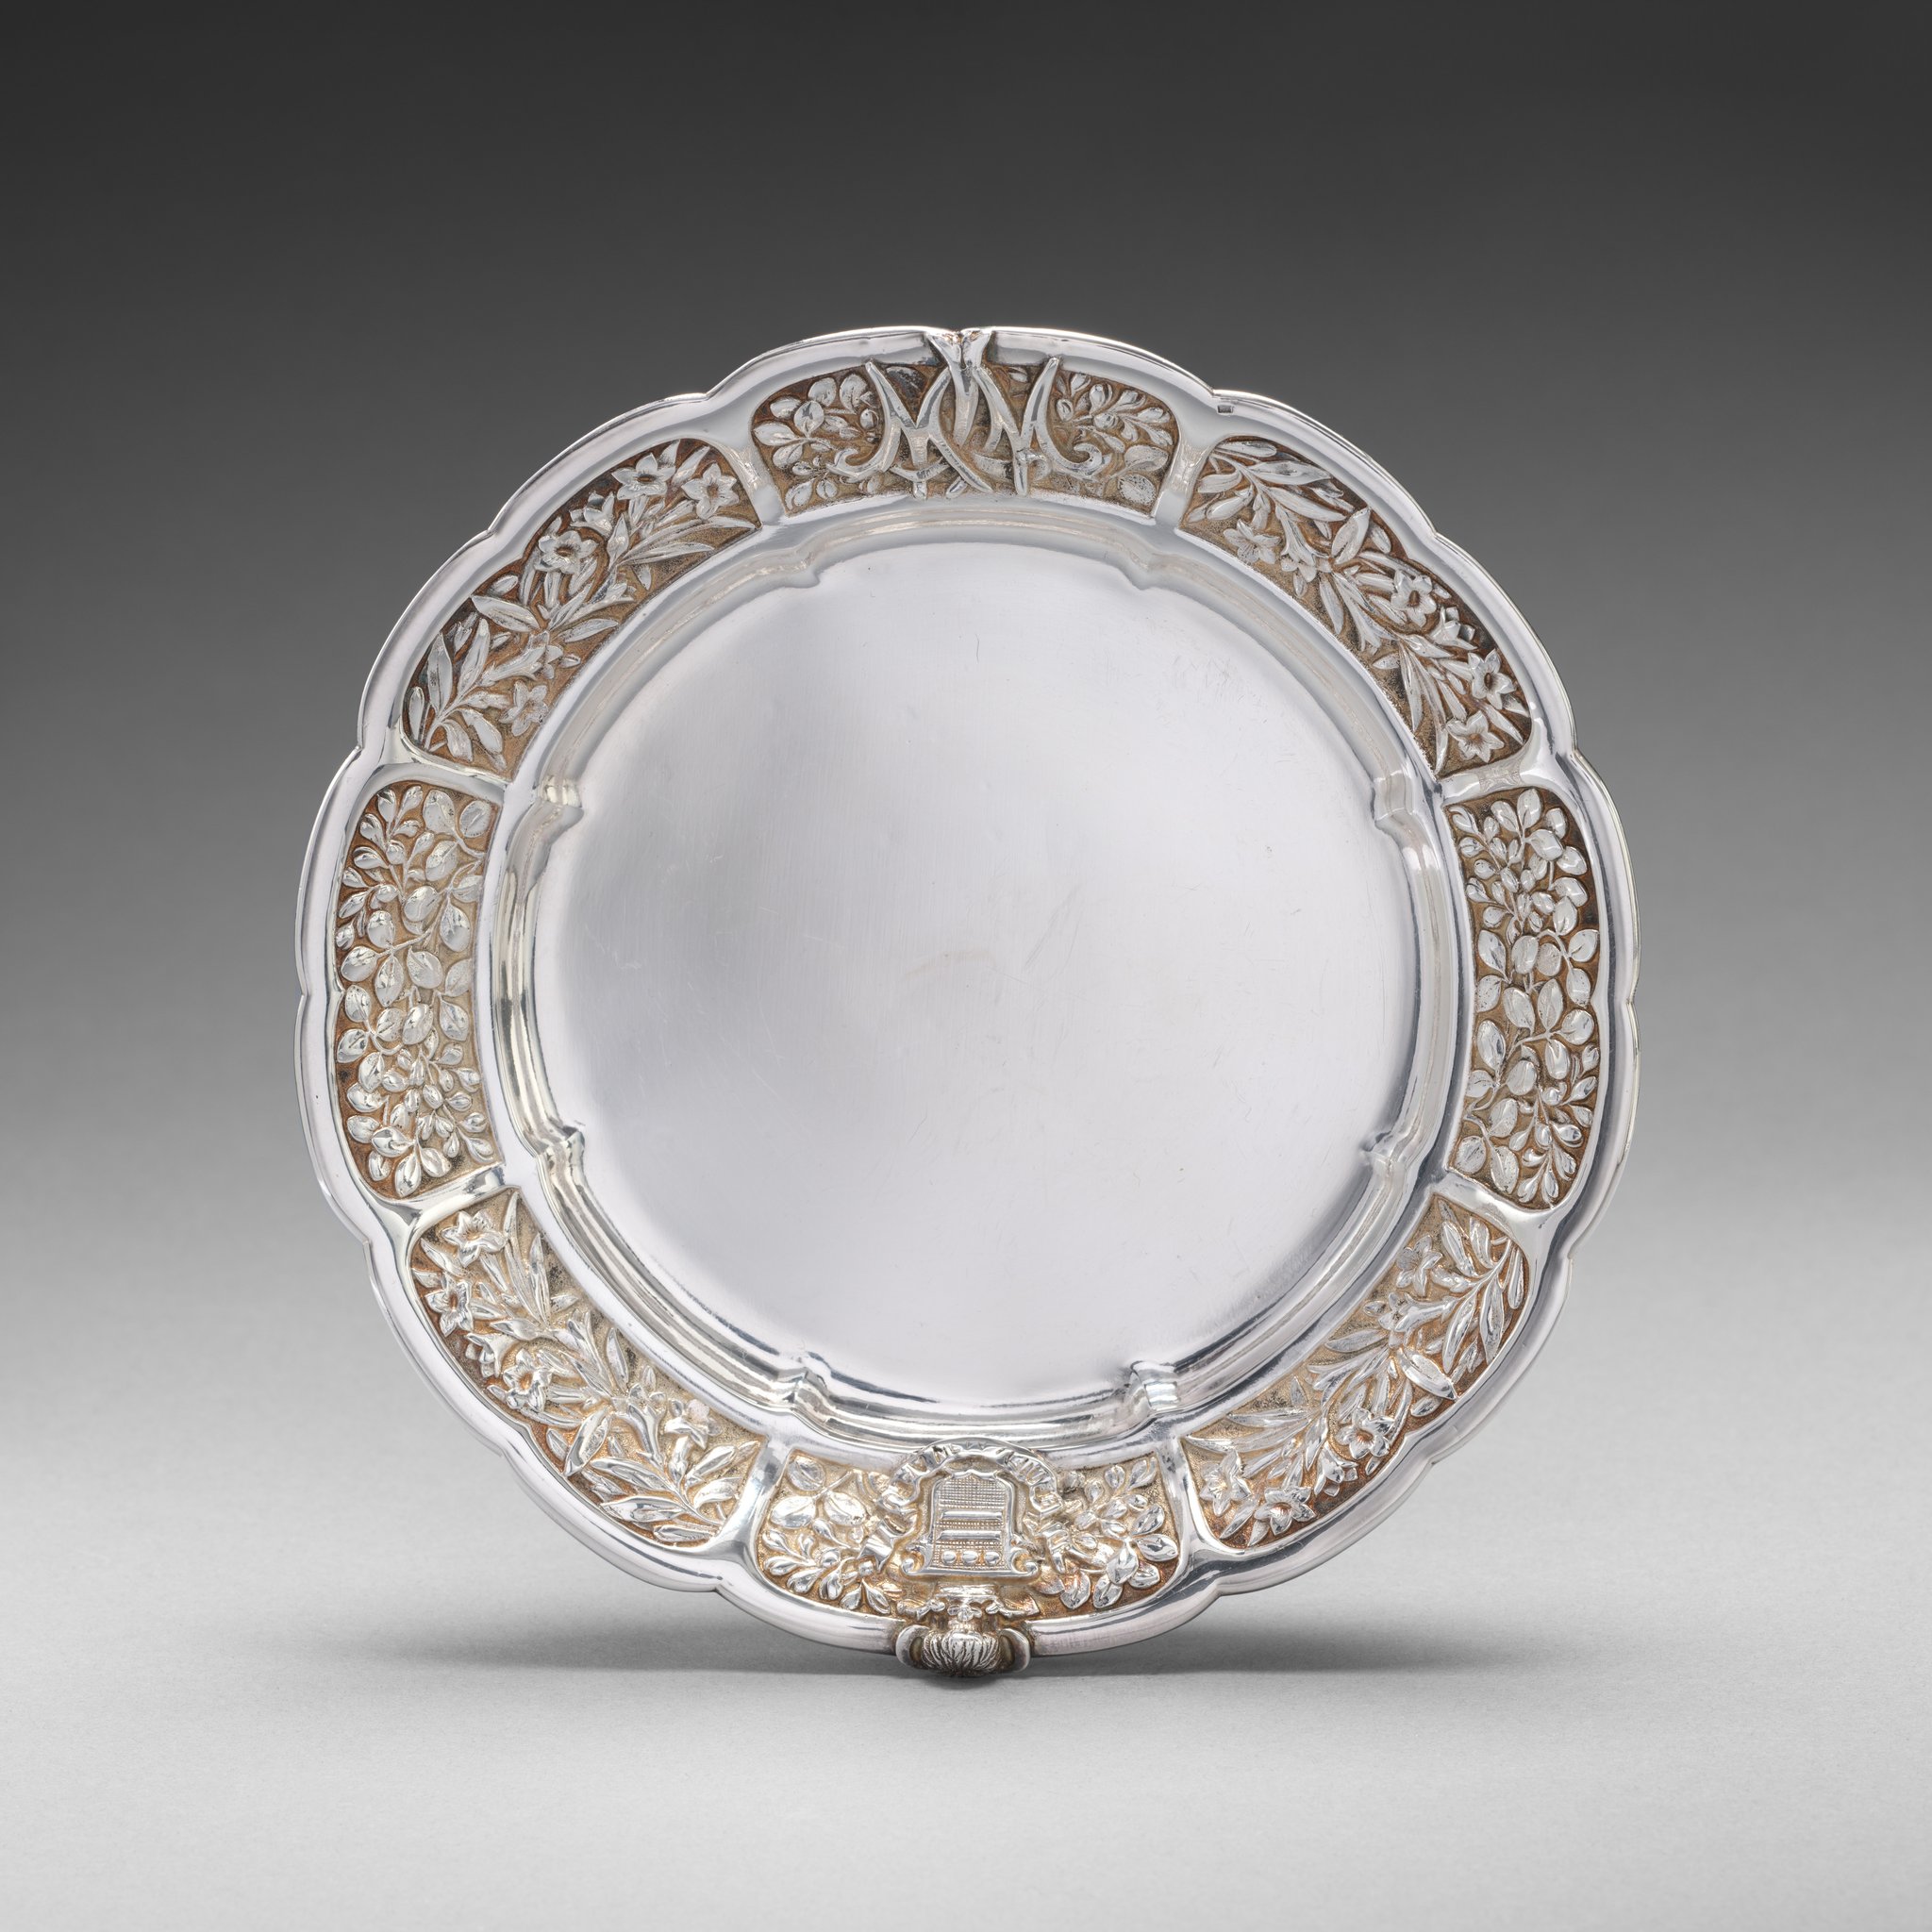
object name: ice cream plate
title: Ice Cream Plate from Mackay Service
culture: american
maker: tiffany & co.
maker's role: maker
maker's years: 1837-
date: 1878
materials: silver